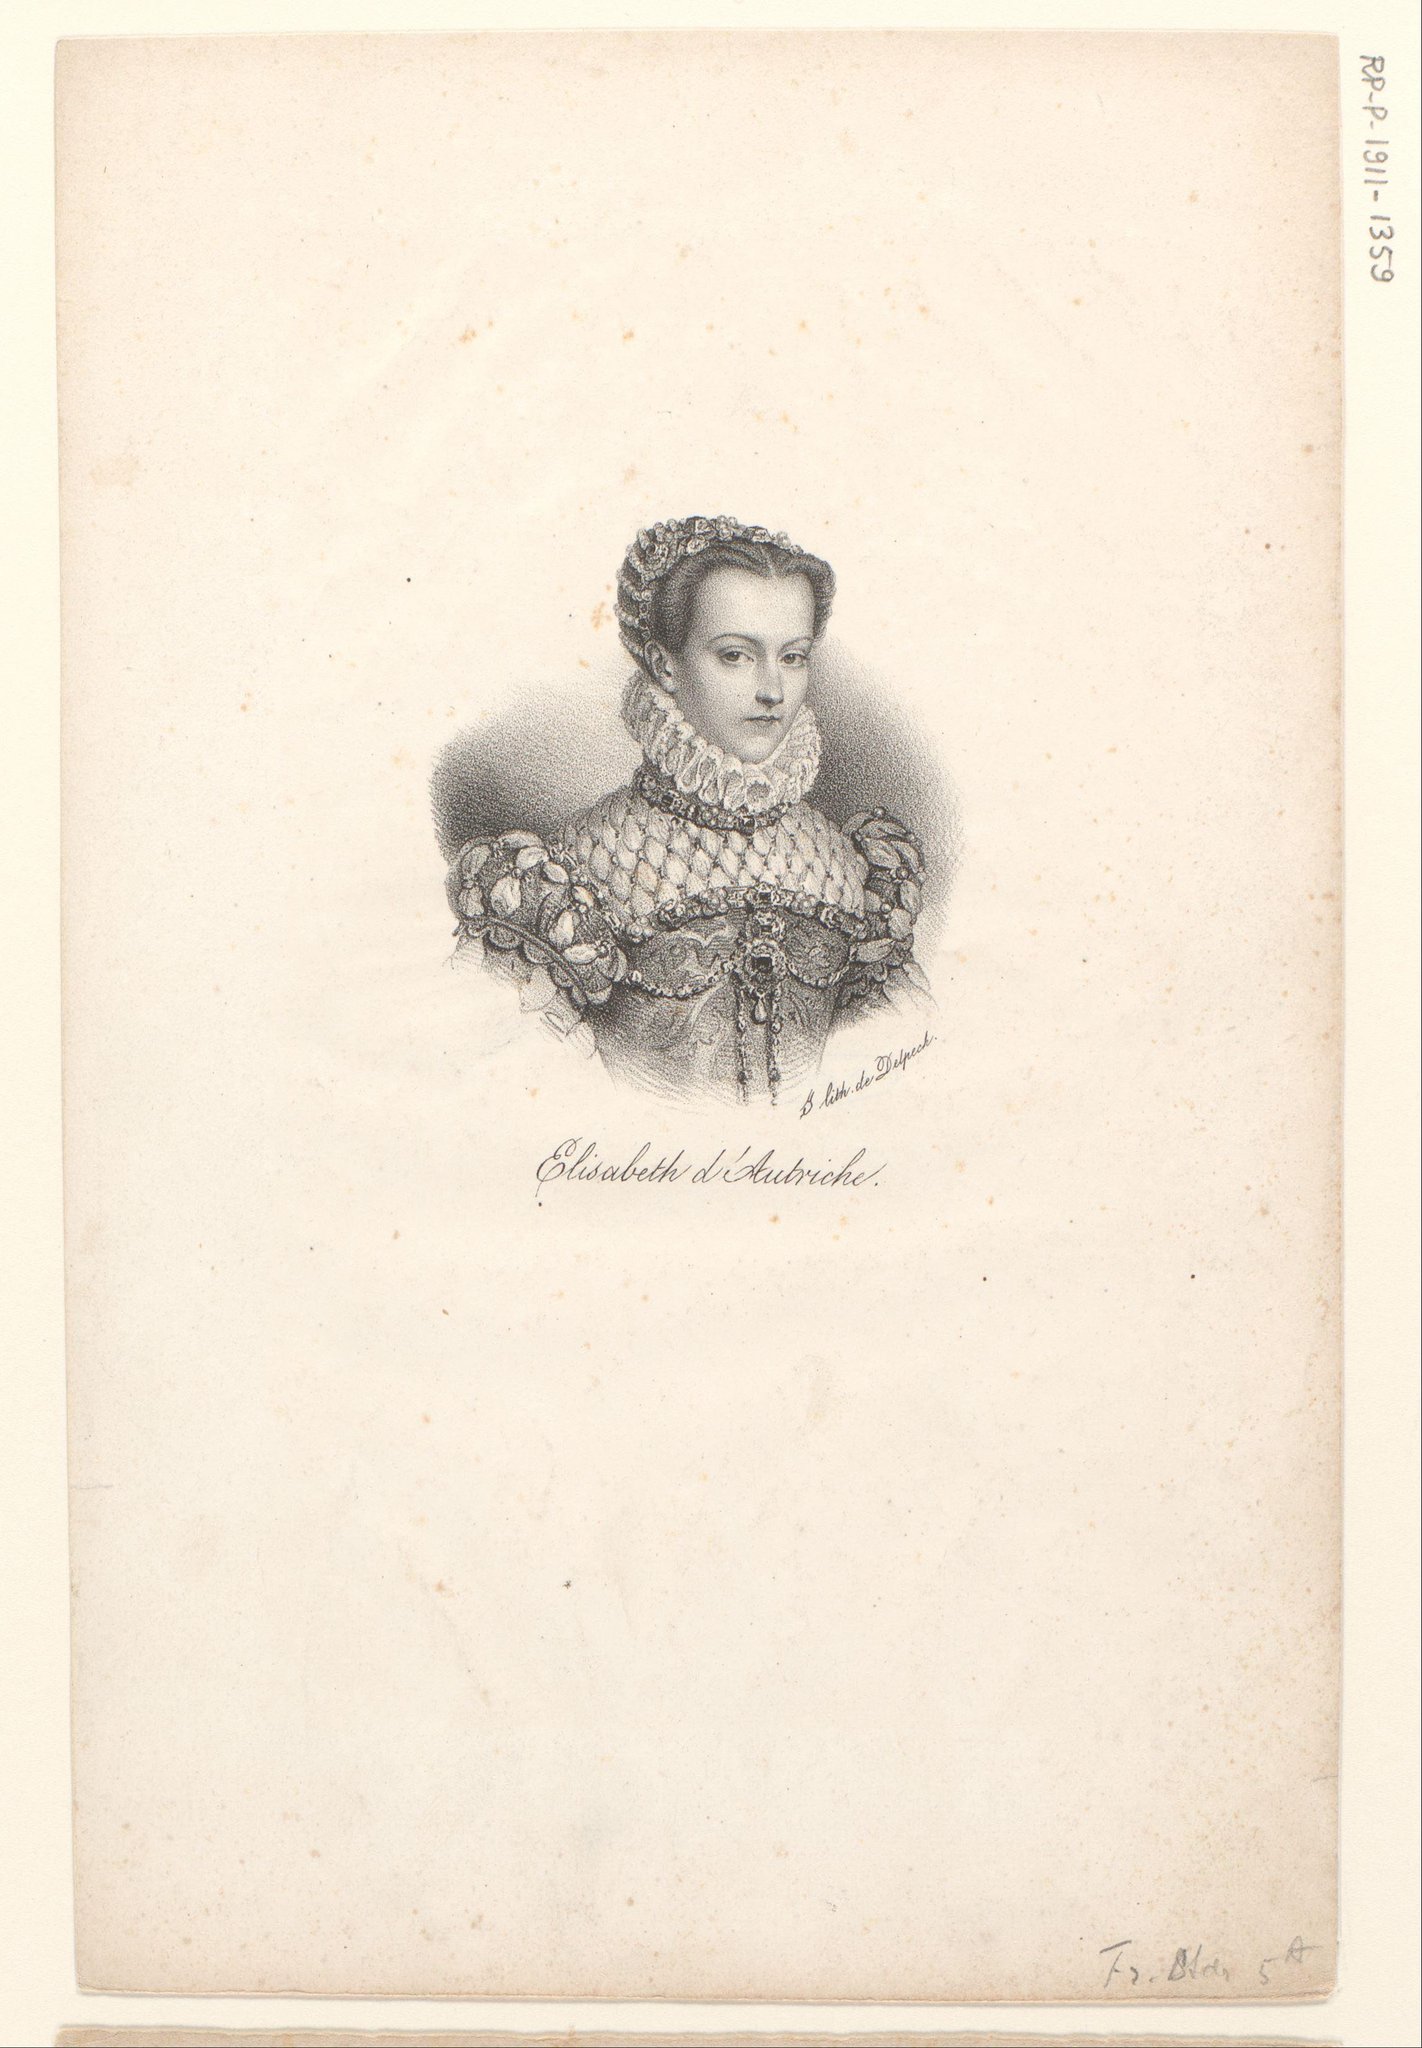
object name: print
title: Elisabeth d'Autriche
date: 1818-1842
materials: paper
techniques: lithograph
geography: paris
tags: historical persons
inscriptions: collector's mark: Lugt 2228a